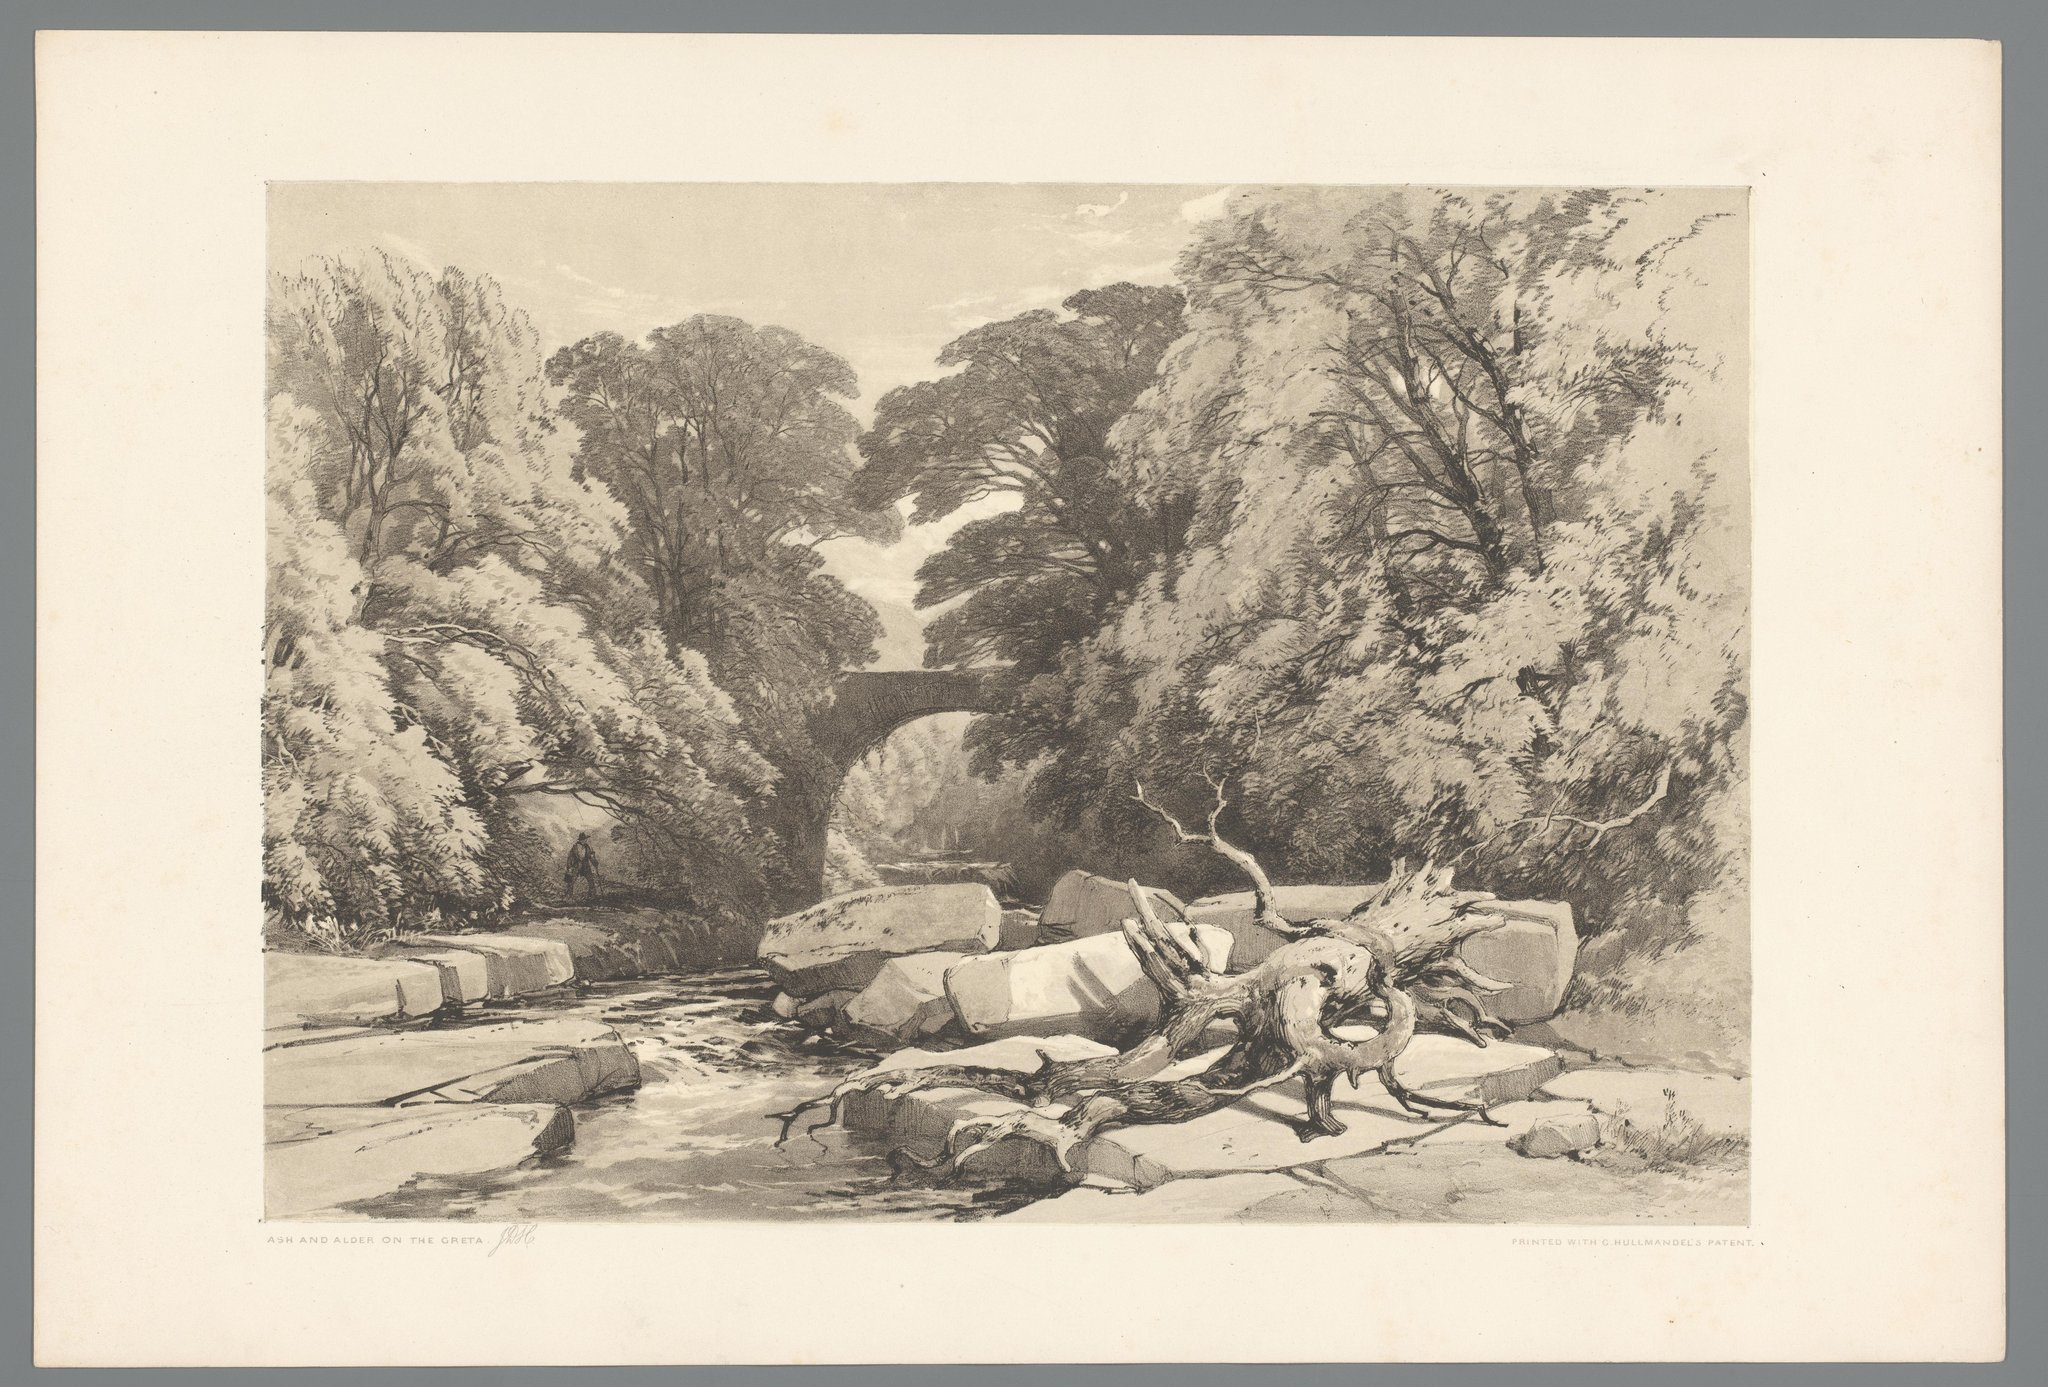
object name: print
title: Gezicht op de rivier Greta in Cumbria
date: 1841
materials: paper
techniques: tone lithography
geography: london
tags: park, forest, wood, river (+ landscape with figures, staffage)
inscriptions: collector's mark: Lugt 2228, collector's mark: Lugt 2760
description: Prent maakt deel uit van een serie van 24 prenten.